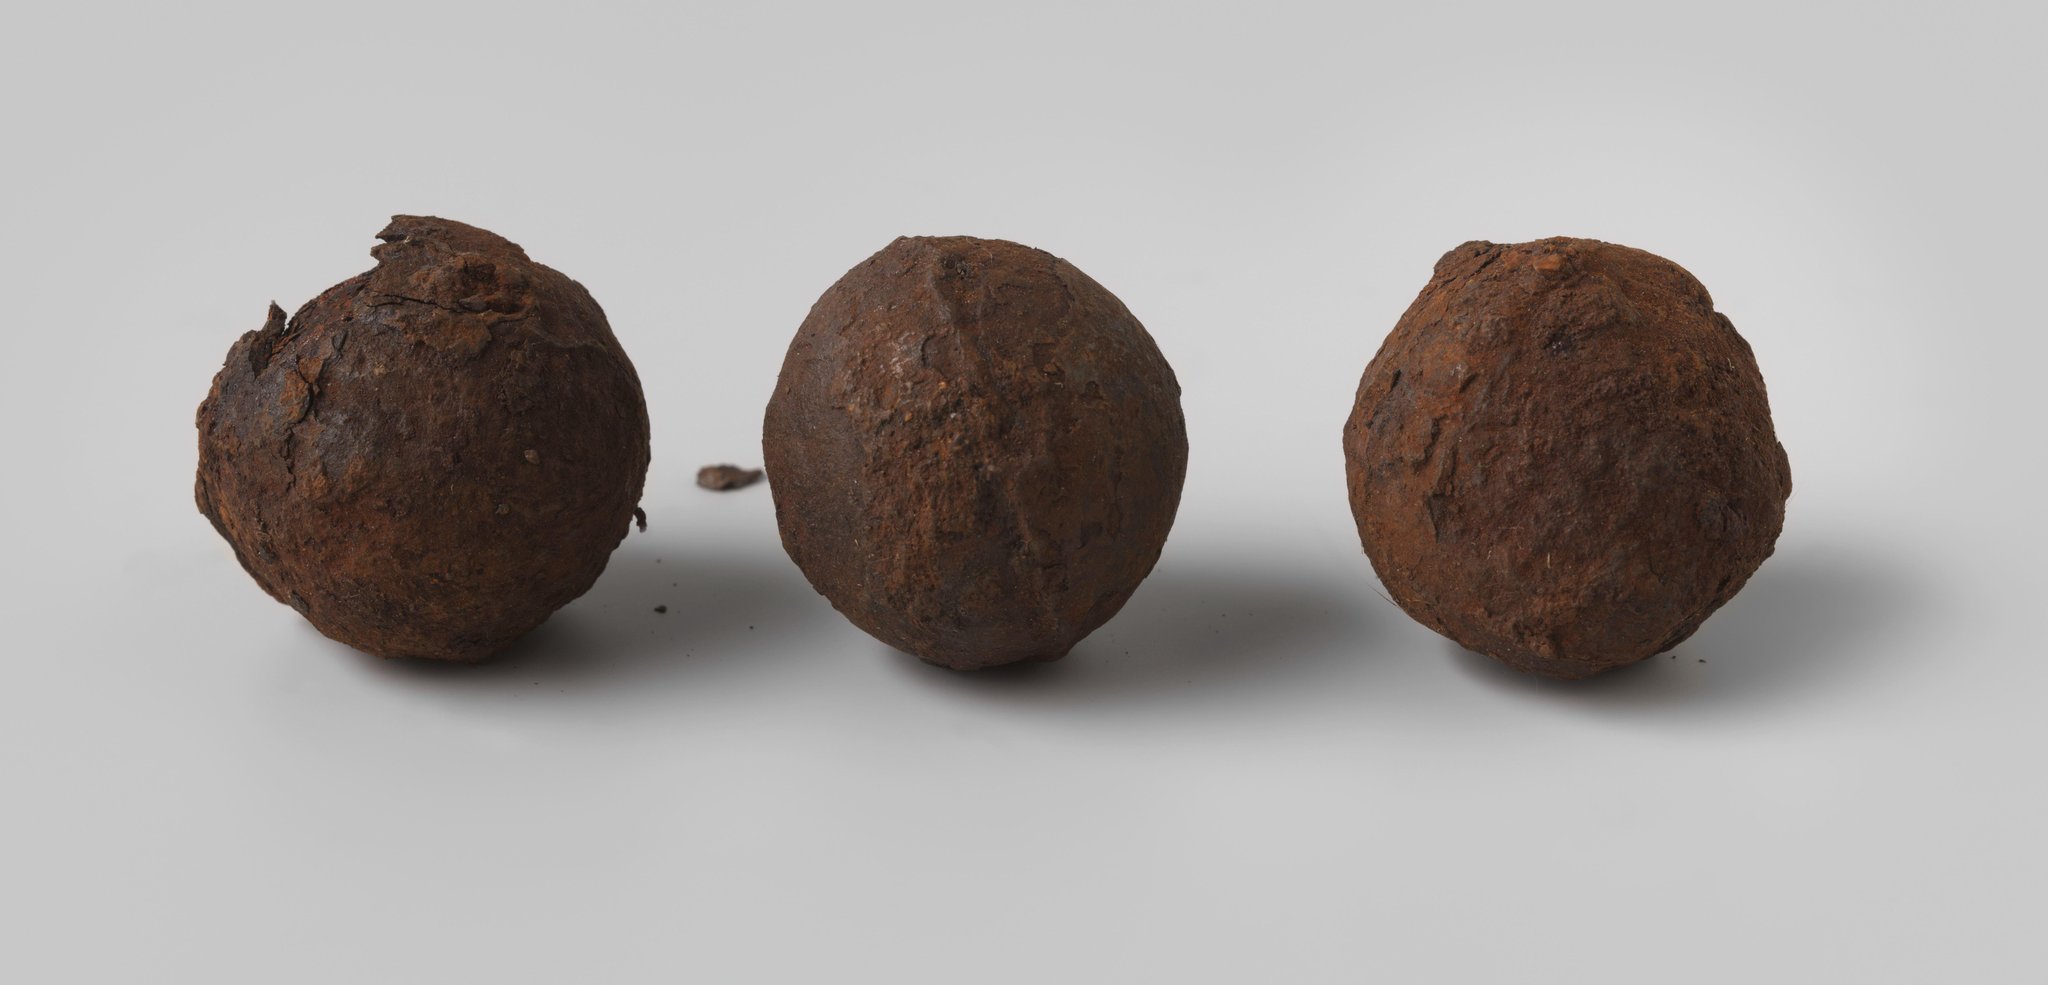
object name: bullet ammunition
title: Kogels uit het wrak van de Oost-Indiëvaarder Hollandia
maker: Anonymous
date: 1700-1743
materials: iron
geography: netherlands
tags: verenigde oostindische compagnie, hollandia (schip), annet